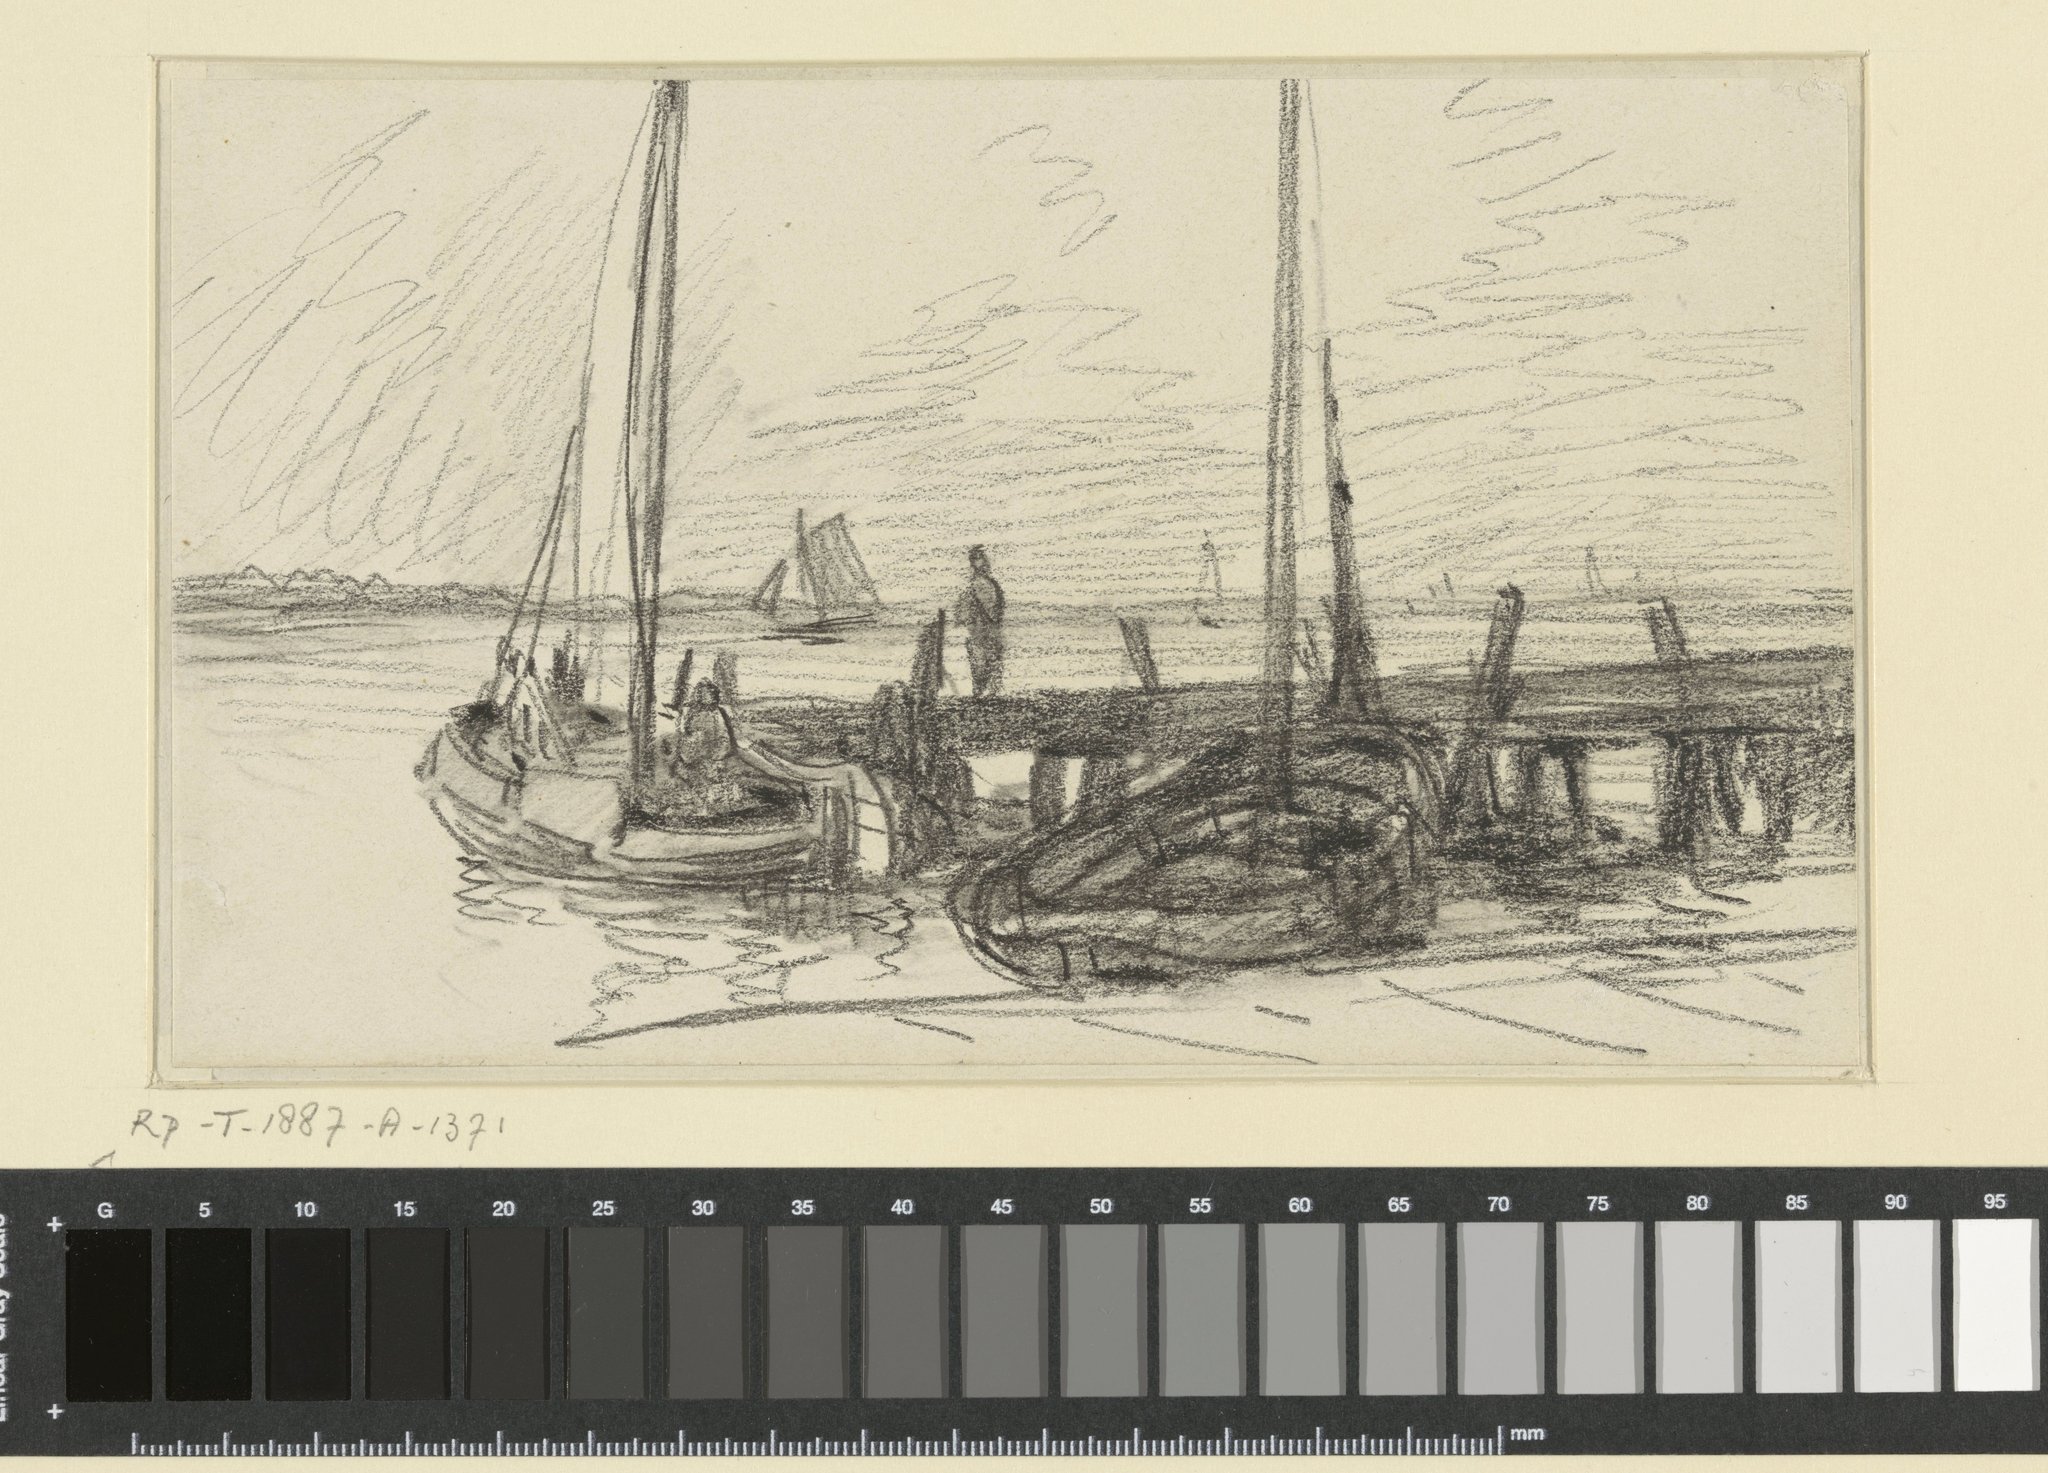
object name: drawing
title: Twee vissersschepen aan een houten havenhoofd waarop een man staat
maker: adolphe mouilleron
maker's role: draughtsman, print maker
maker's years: 1820-1881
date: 1830-1881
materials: chalk, paper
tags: sailing-ship, sailing-boat, pier, quay, wharf